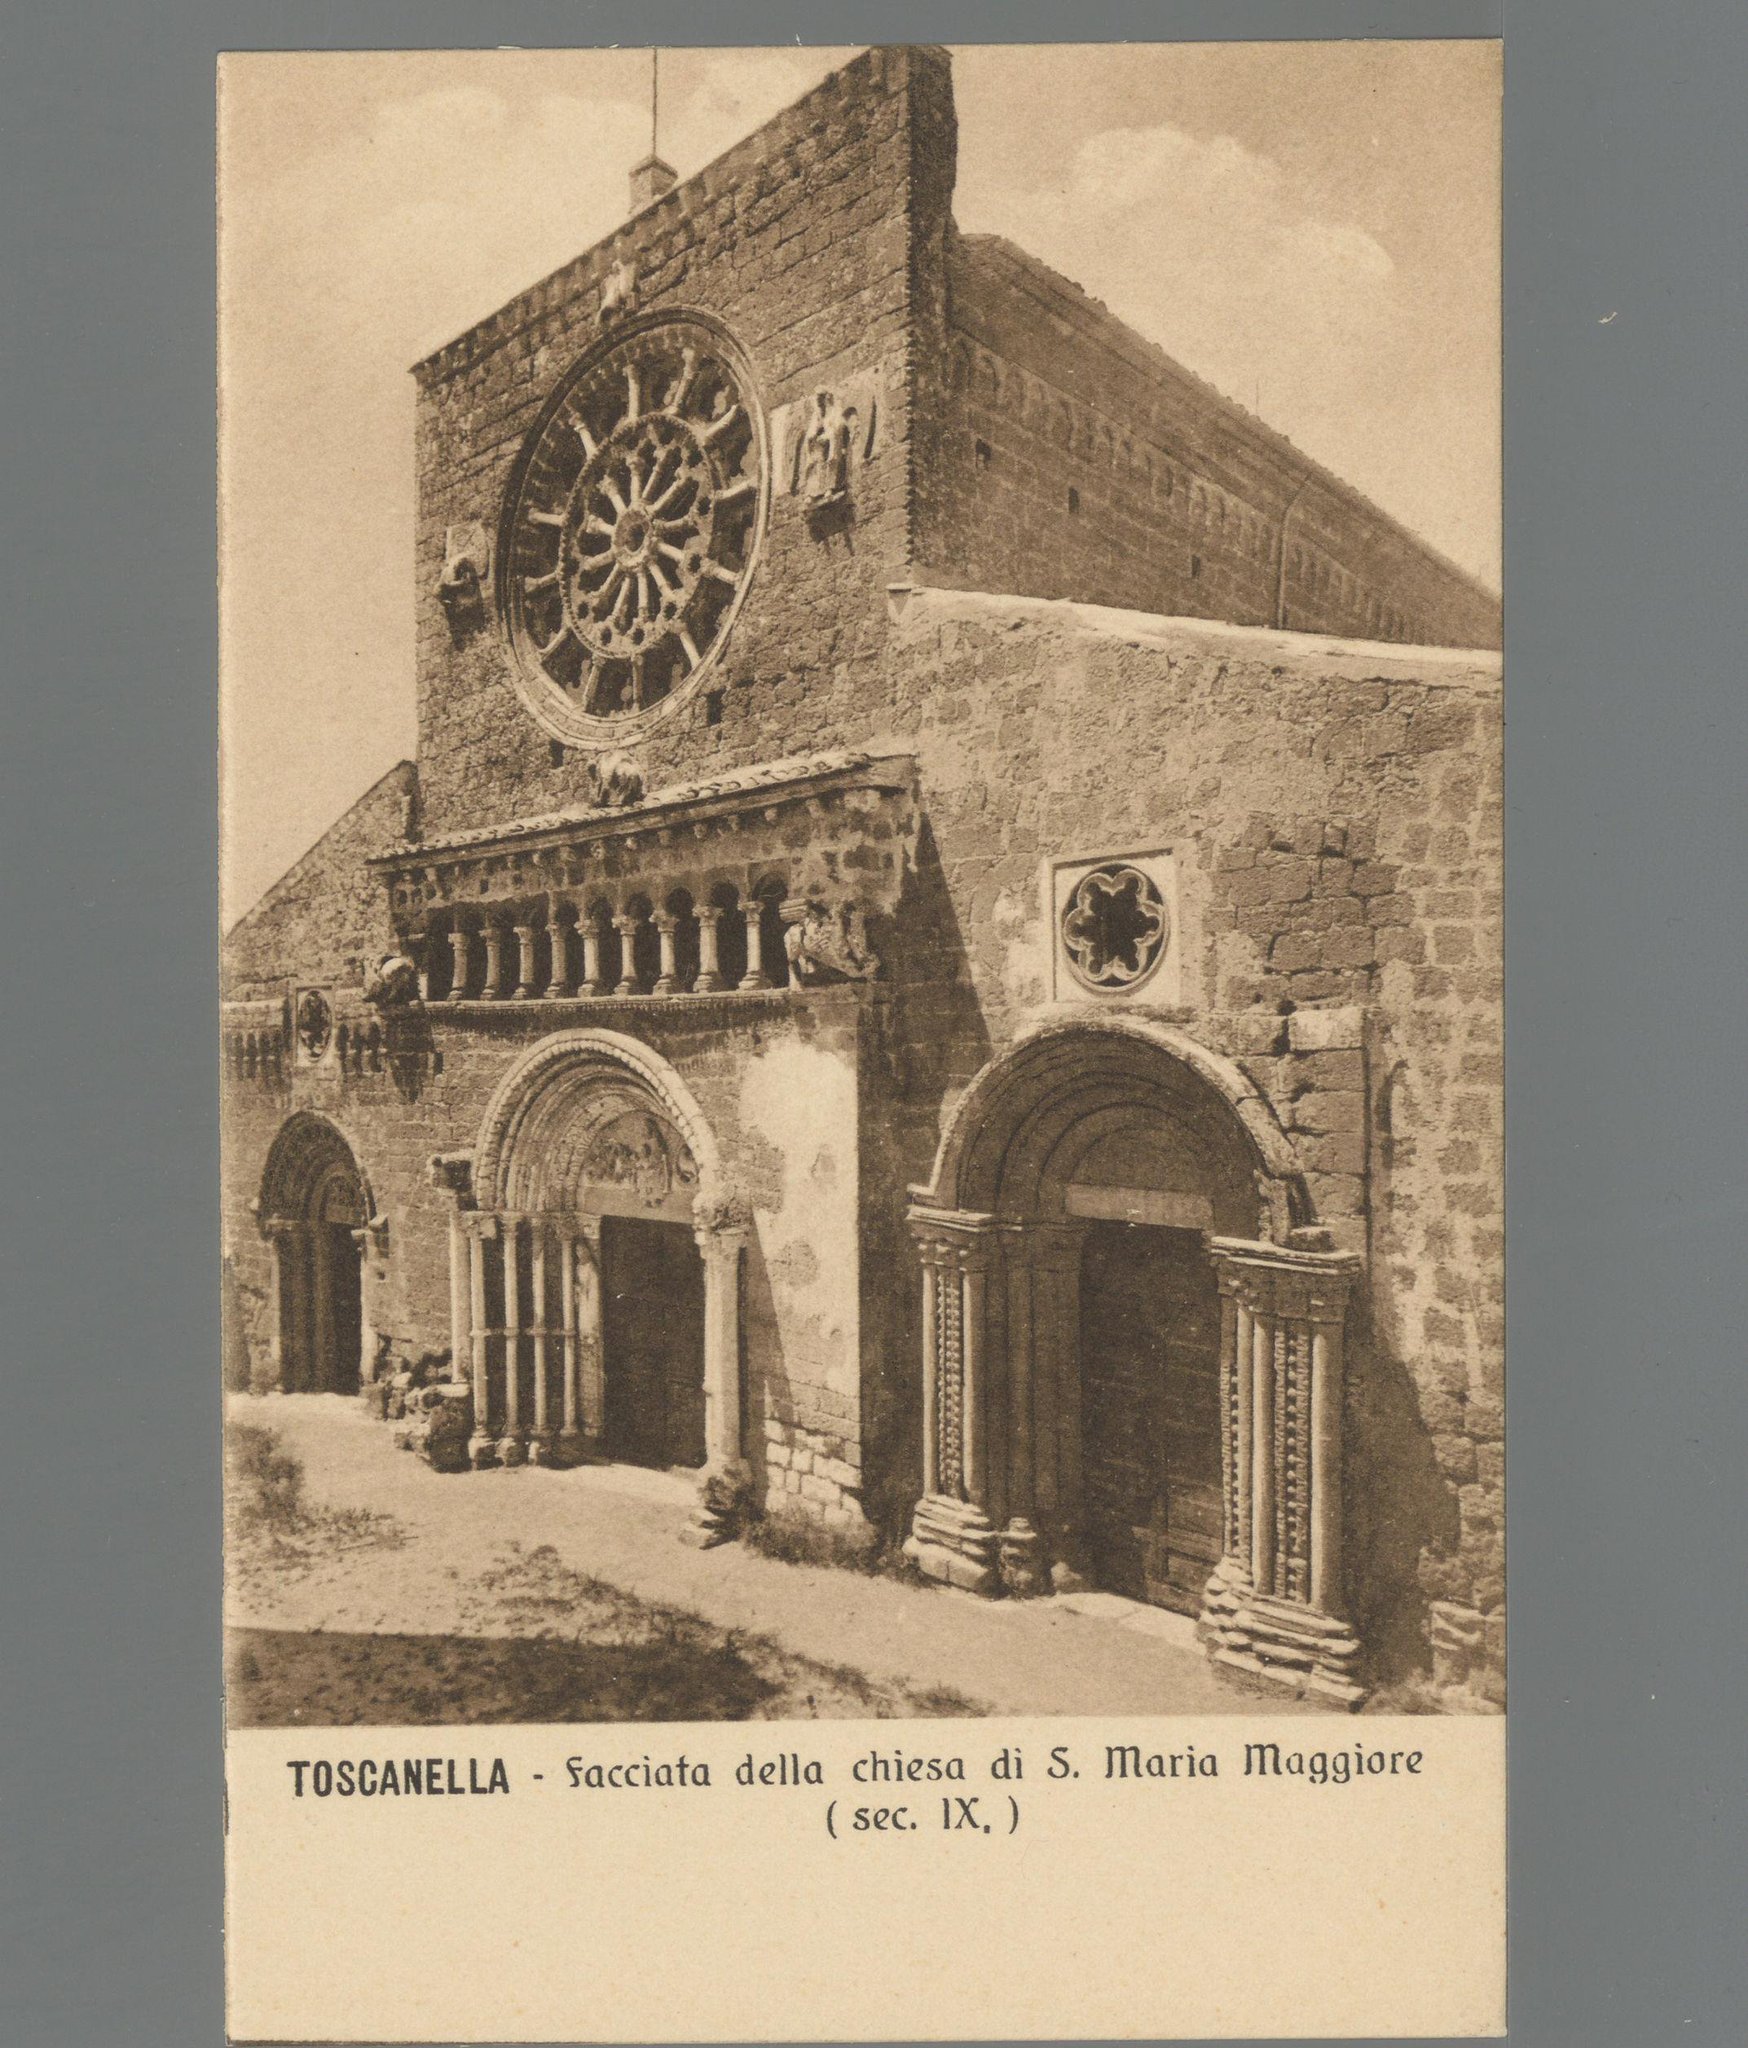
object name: ansichtkaart, prentbriefkaart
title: Toscanella. Facciata della chiesa di S. Maria Maggiore (sec. IX)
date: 1906-1920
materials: cardboard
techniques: photograph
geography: italy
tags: church (exterior)